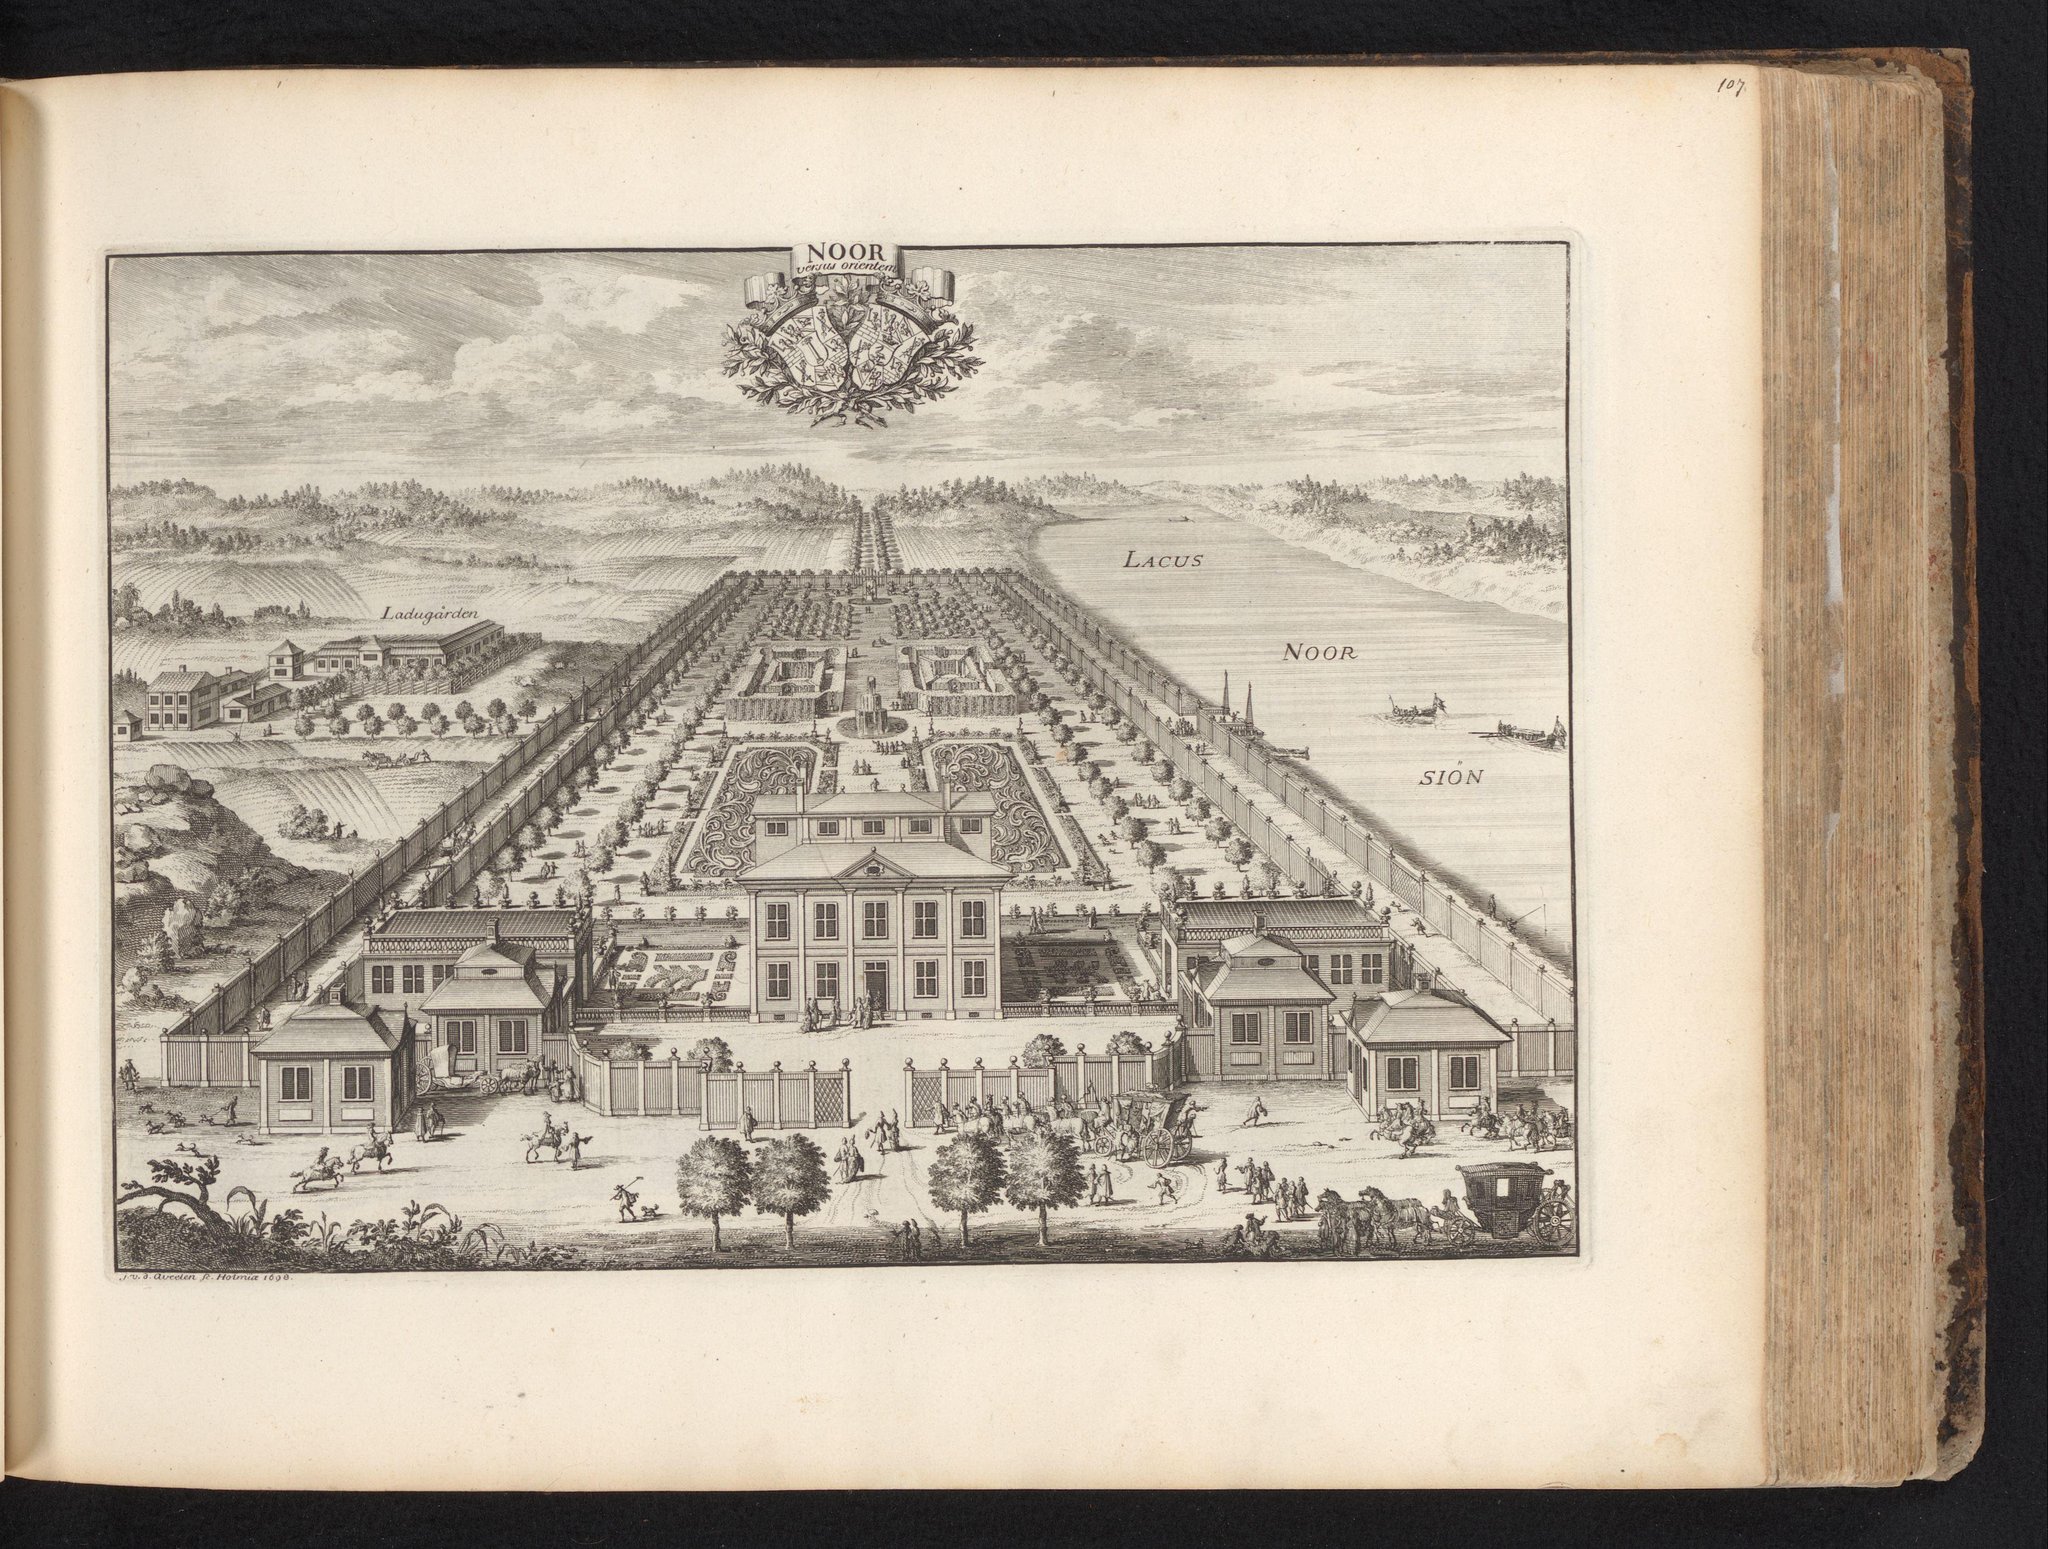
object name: print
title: Suecia Antiqua et Hodierna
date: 1698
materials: paper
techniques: etching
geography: stockholm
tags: palace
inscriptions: date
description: Kungliga Biblioteket, 'Suecia': http://www.kb.se/samlingarna/Kartor-bilder/Suecia-antiqua/ (geraadpleegd november 2016).